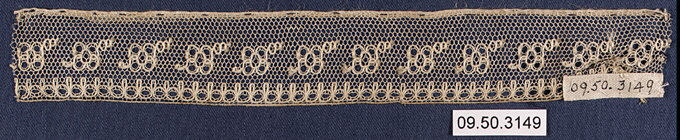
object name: strip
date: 1801-1900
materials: lace